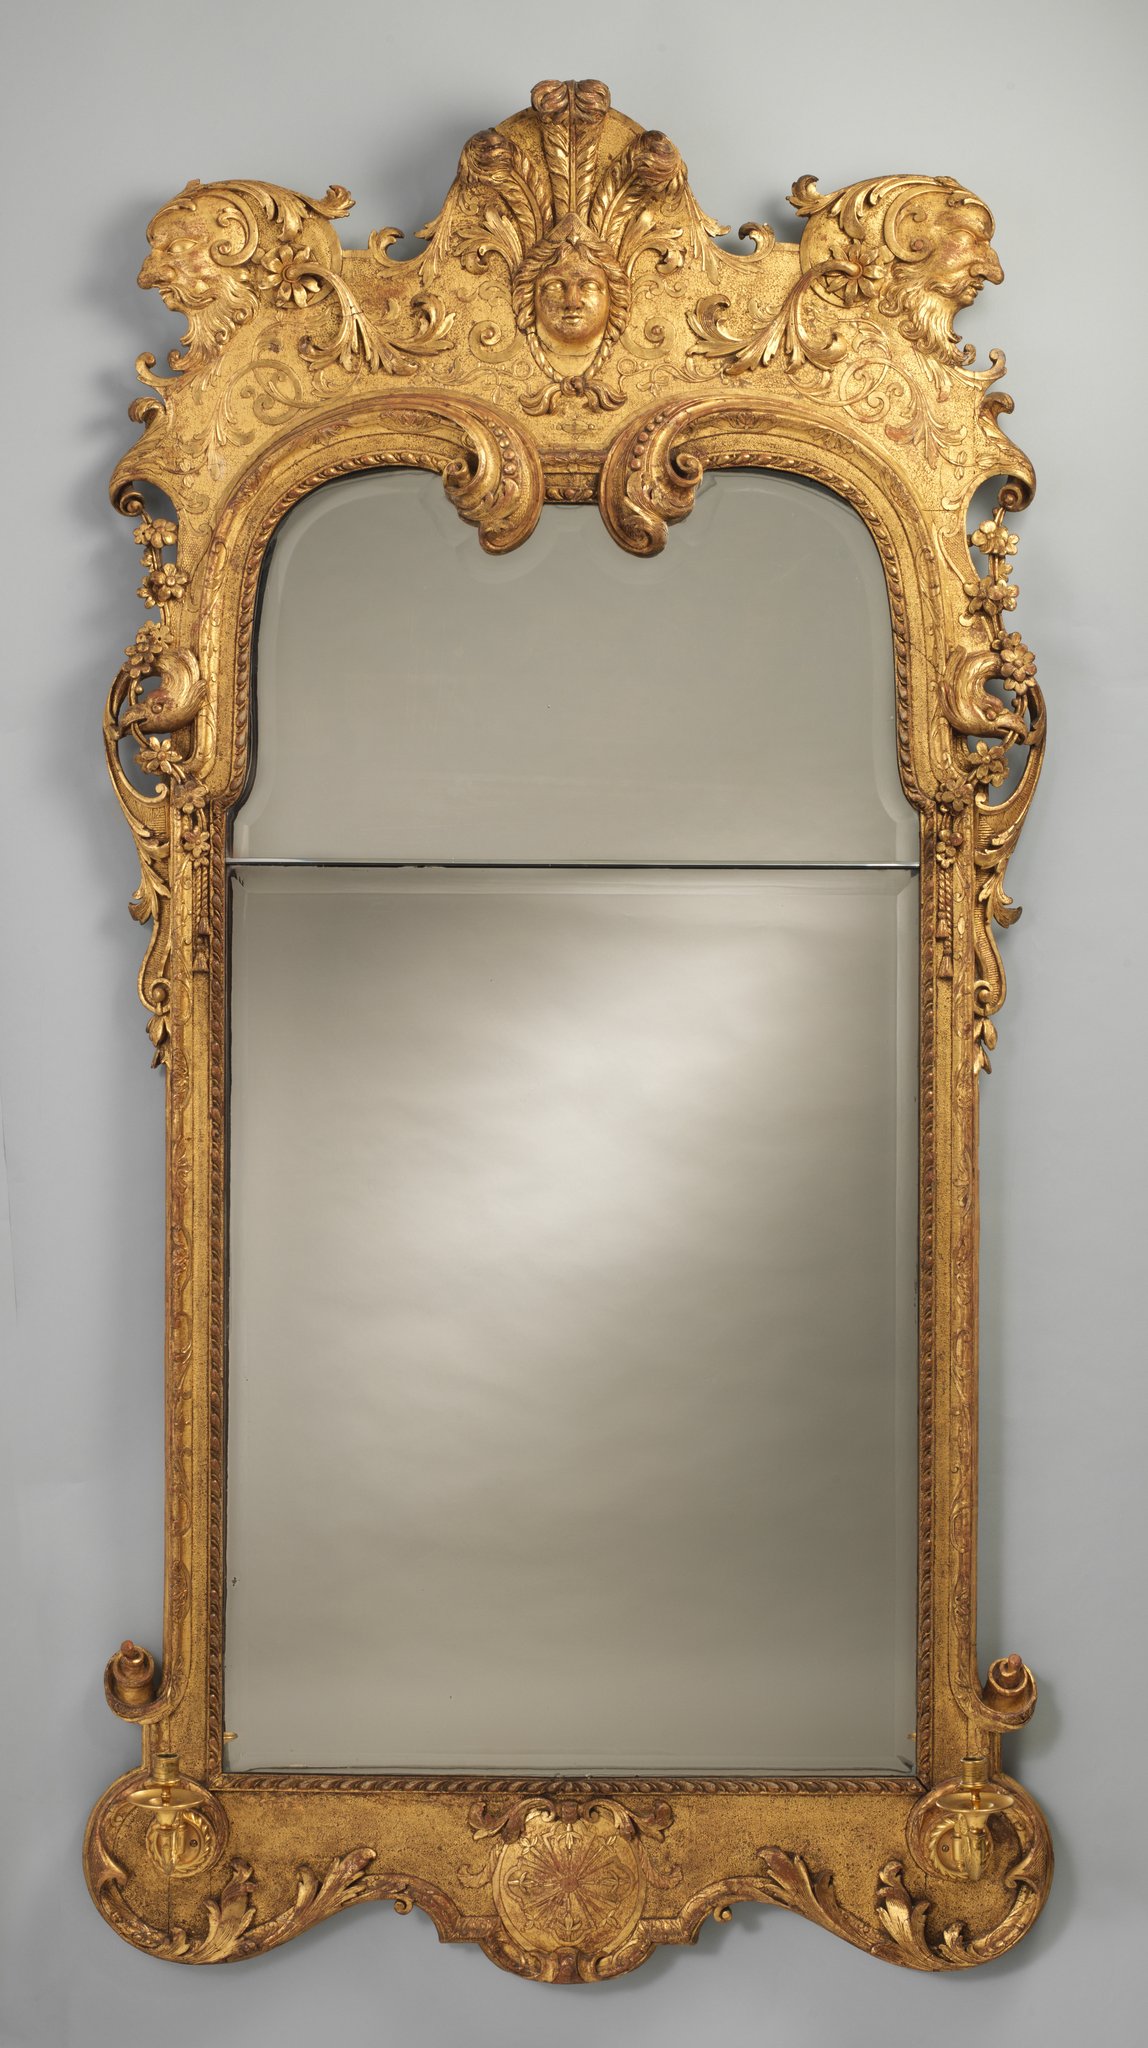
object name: mirror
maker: john belchier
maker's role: maker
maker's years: 1653-1753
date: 1720-1725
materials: gesso, wood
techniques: gilding